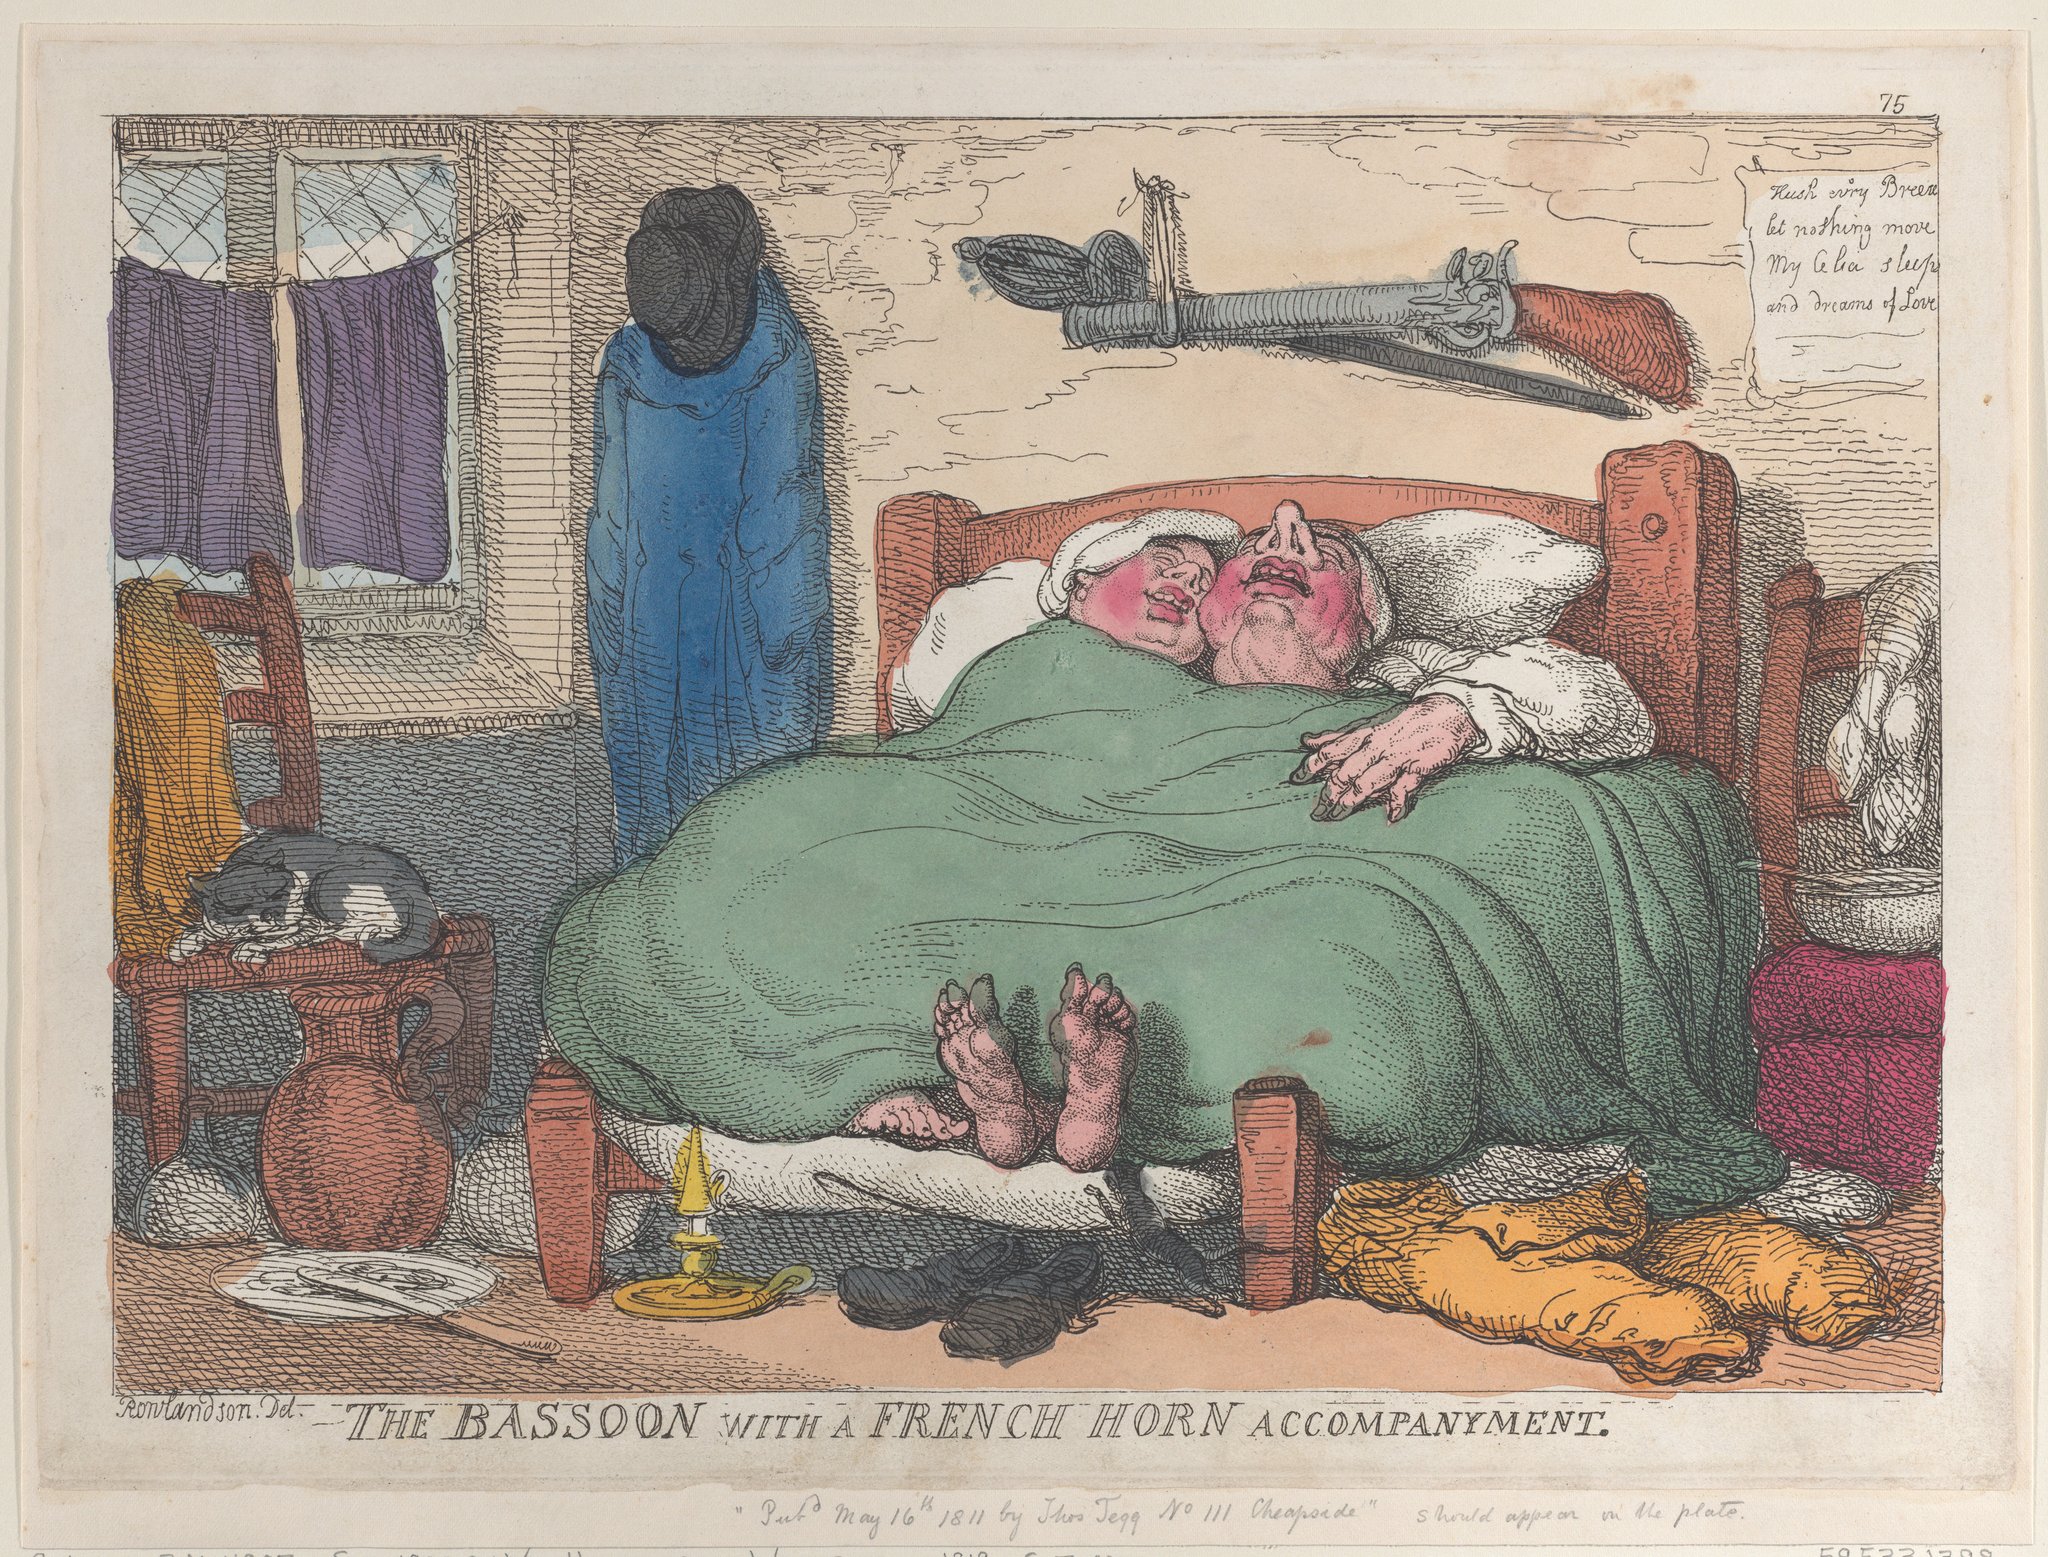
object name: print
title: The Bassoon with a French Horn Accompaniment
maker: thomas rowlandson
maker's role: artist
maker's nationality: british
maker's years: 1757-1827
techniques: etching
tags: satire,sleeping,men,women,cats,beds